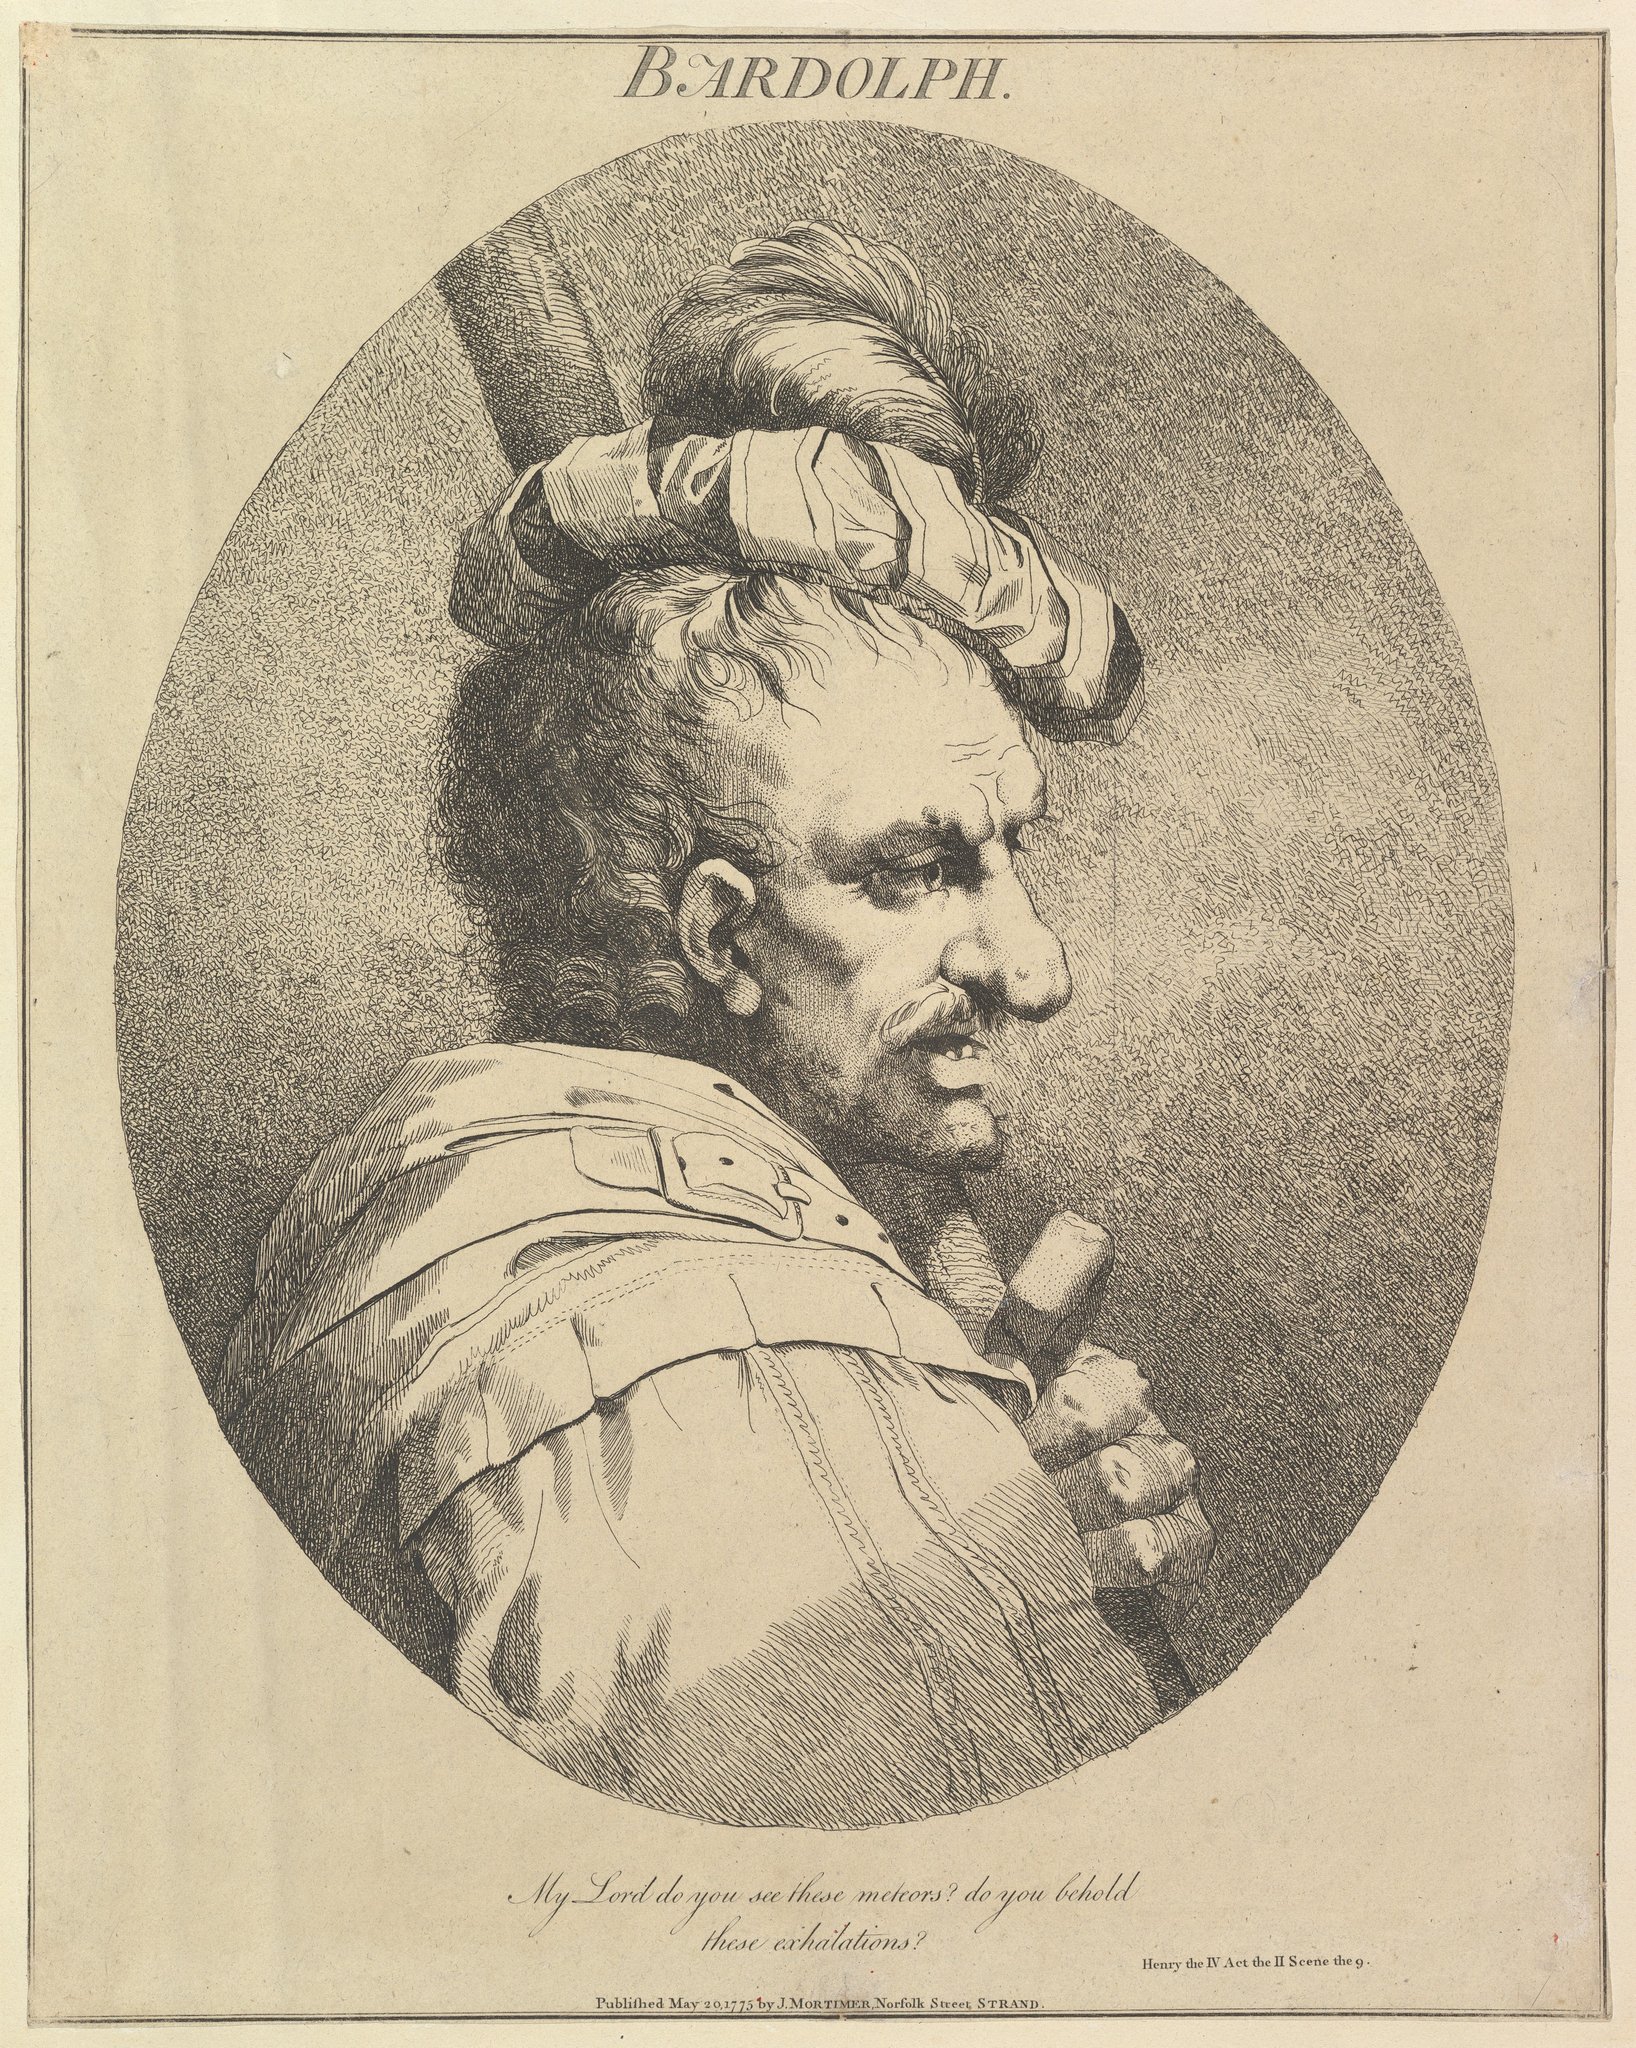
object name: print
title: Bardolph, from "Twelve Characters from Shakespeare"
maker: john hamilton mortimer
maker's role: artist and publisher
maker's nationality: british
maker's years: 1740-1779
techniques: etching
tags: shakespeare,men